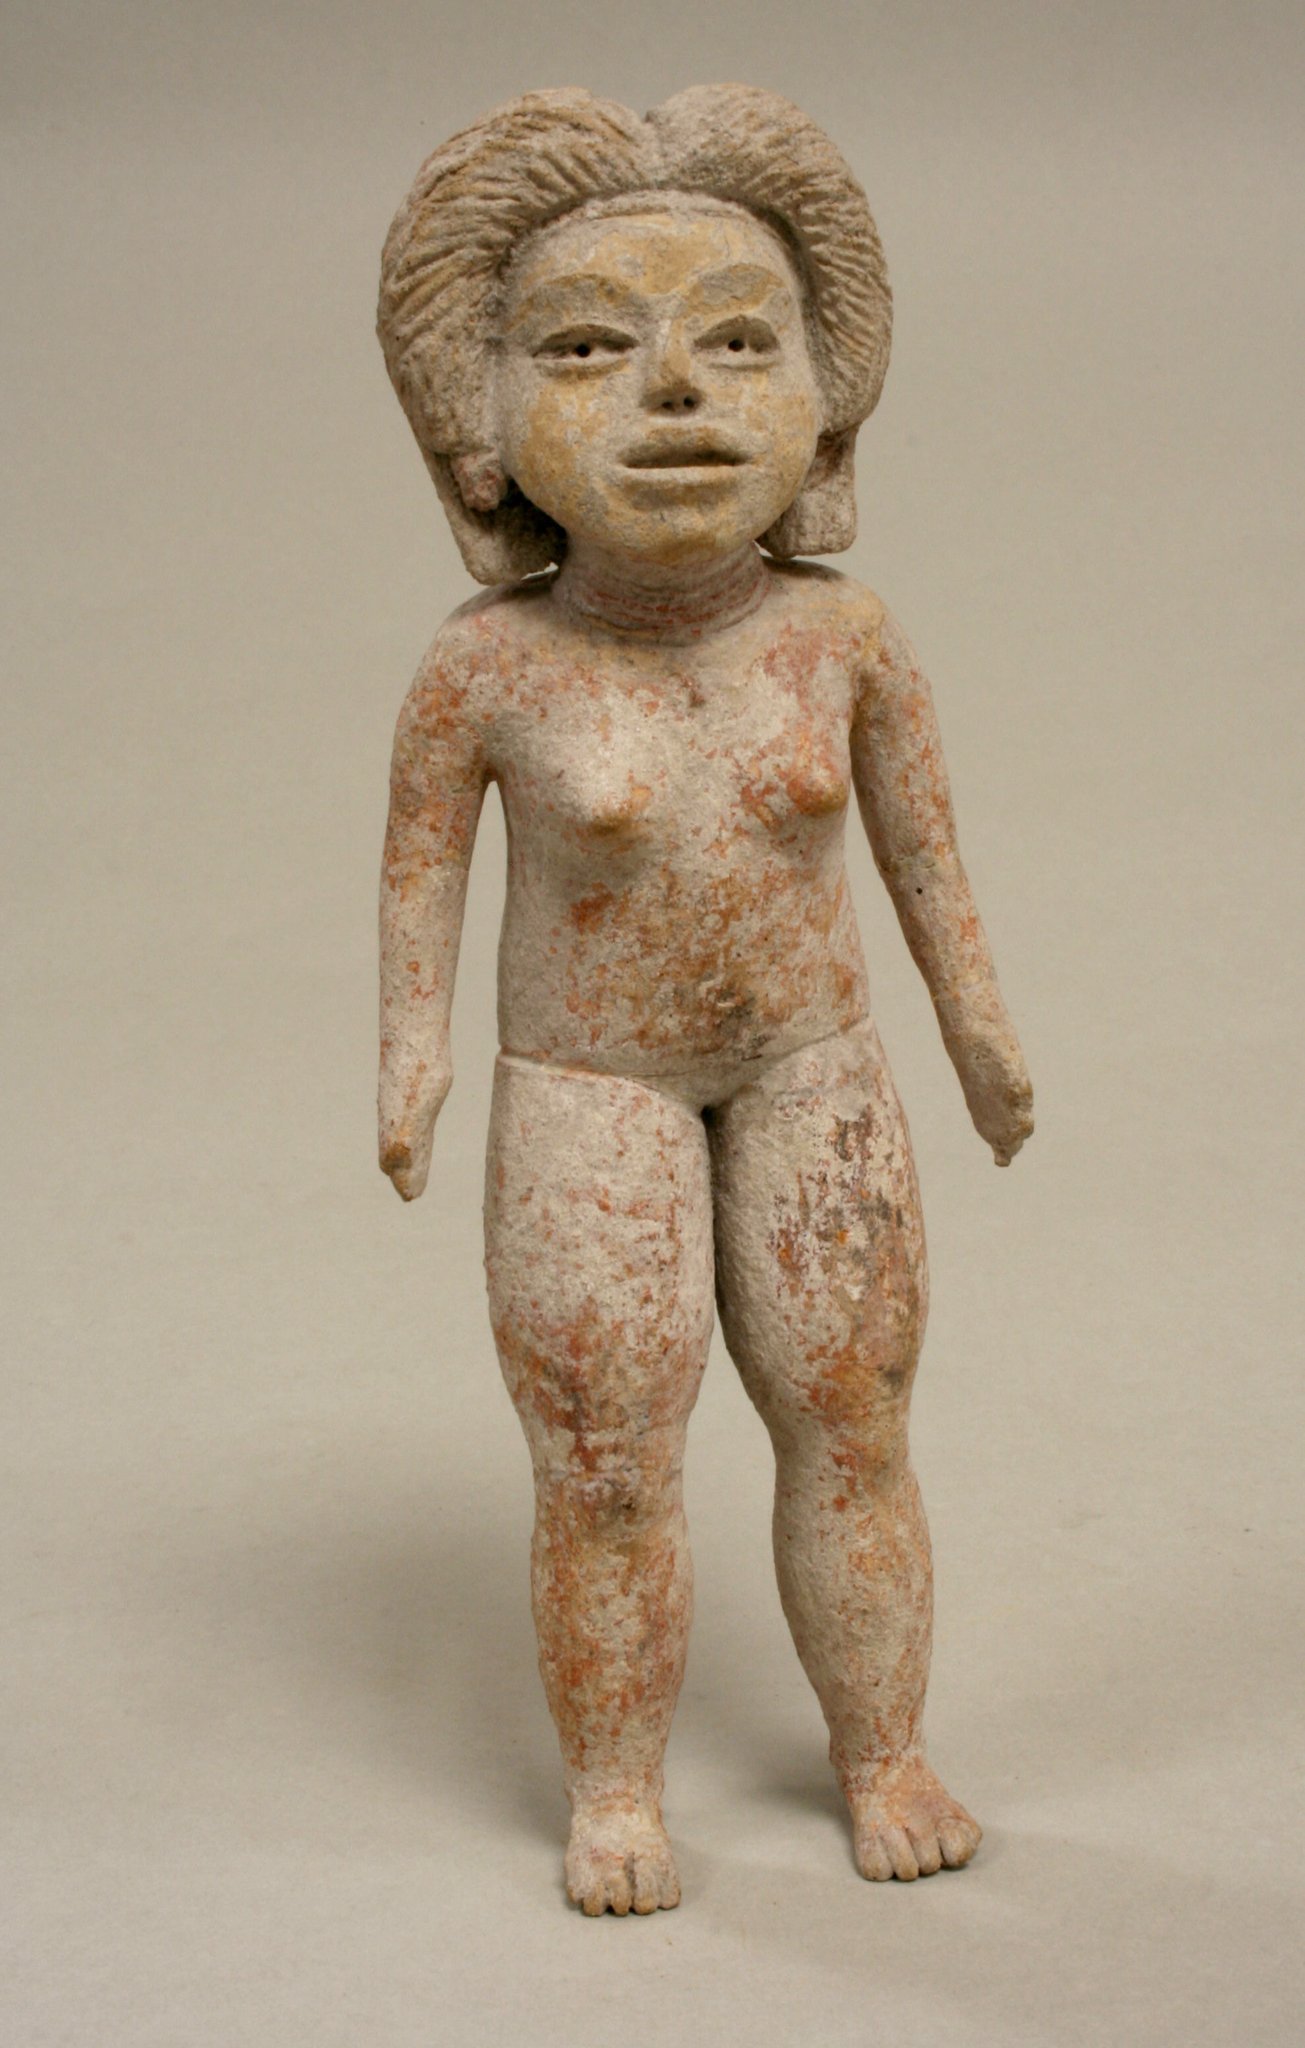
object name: female figure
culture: xochipala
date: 500 BCE-250 CE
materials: ceramic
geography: mexico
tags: female nudes